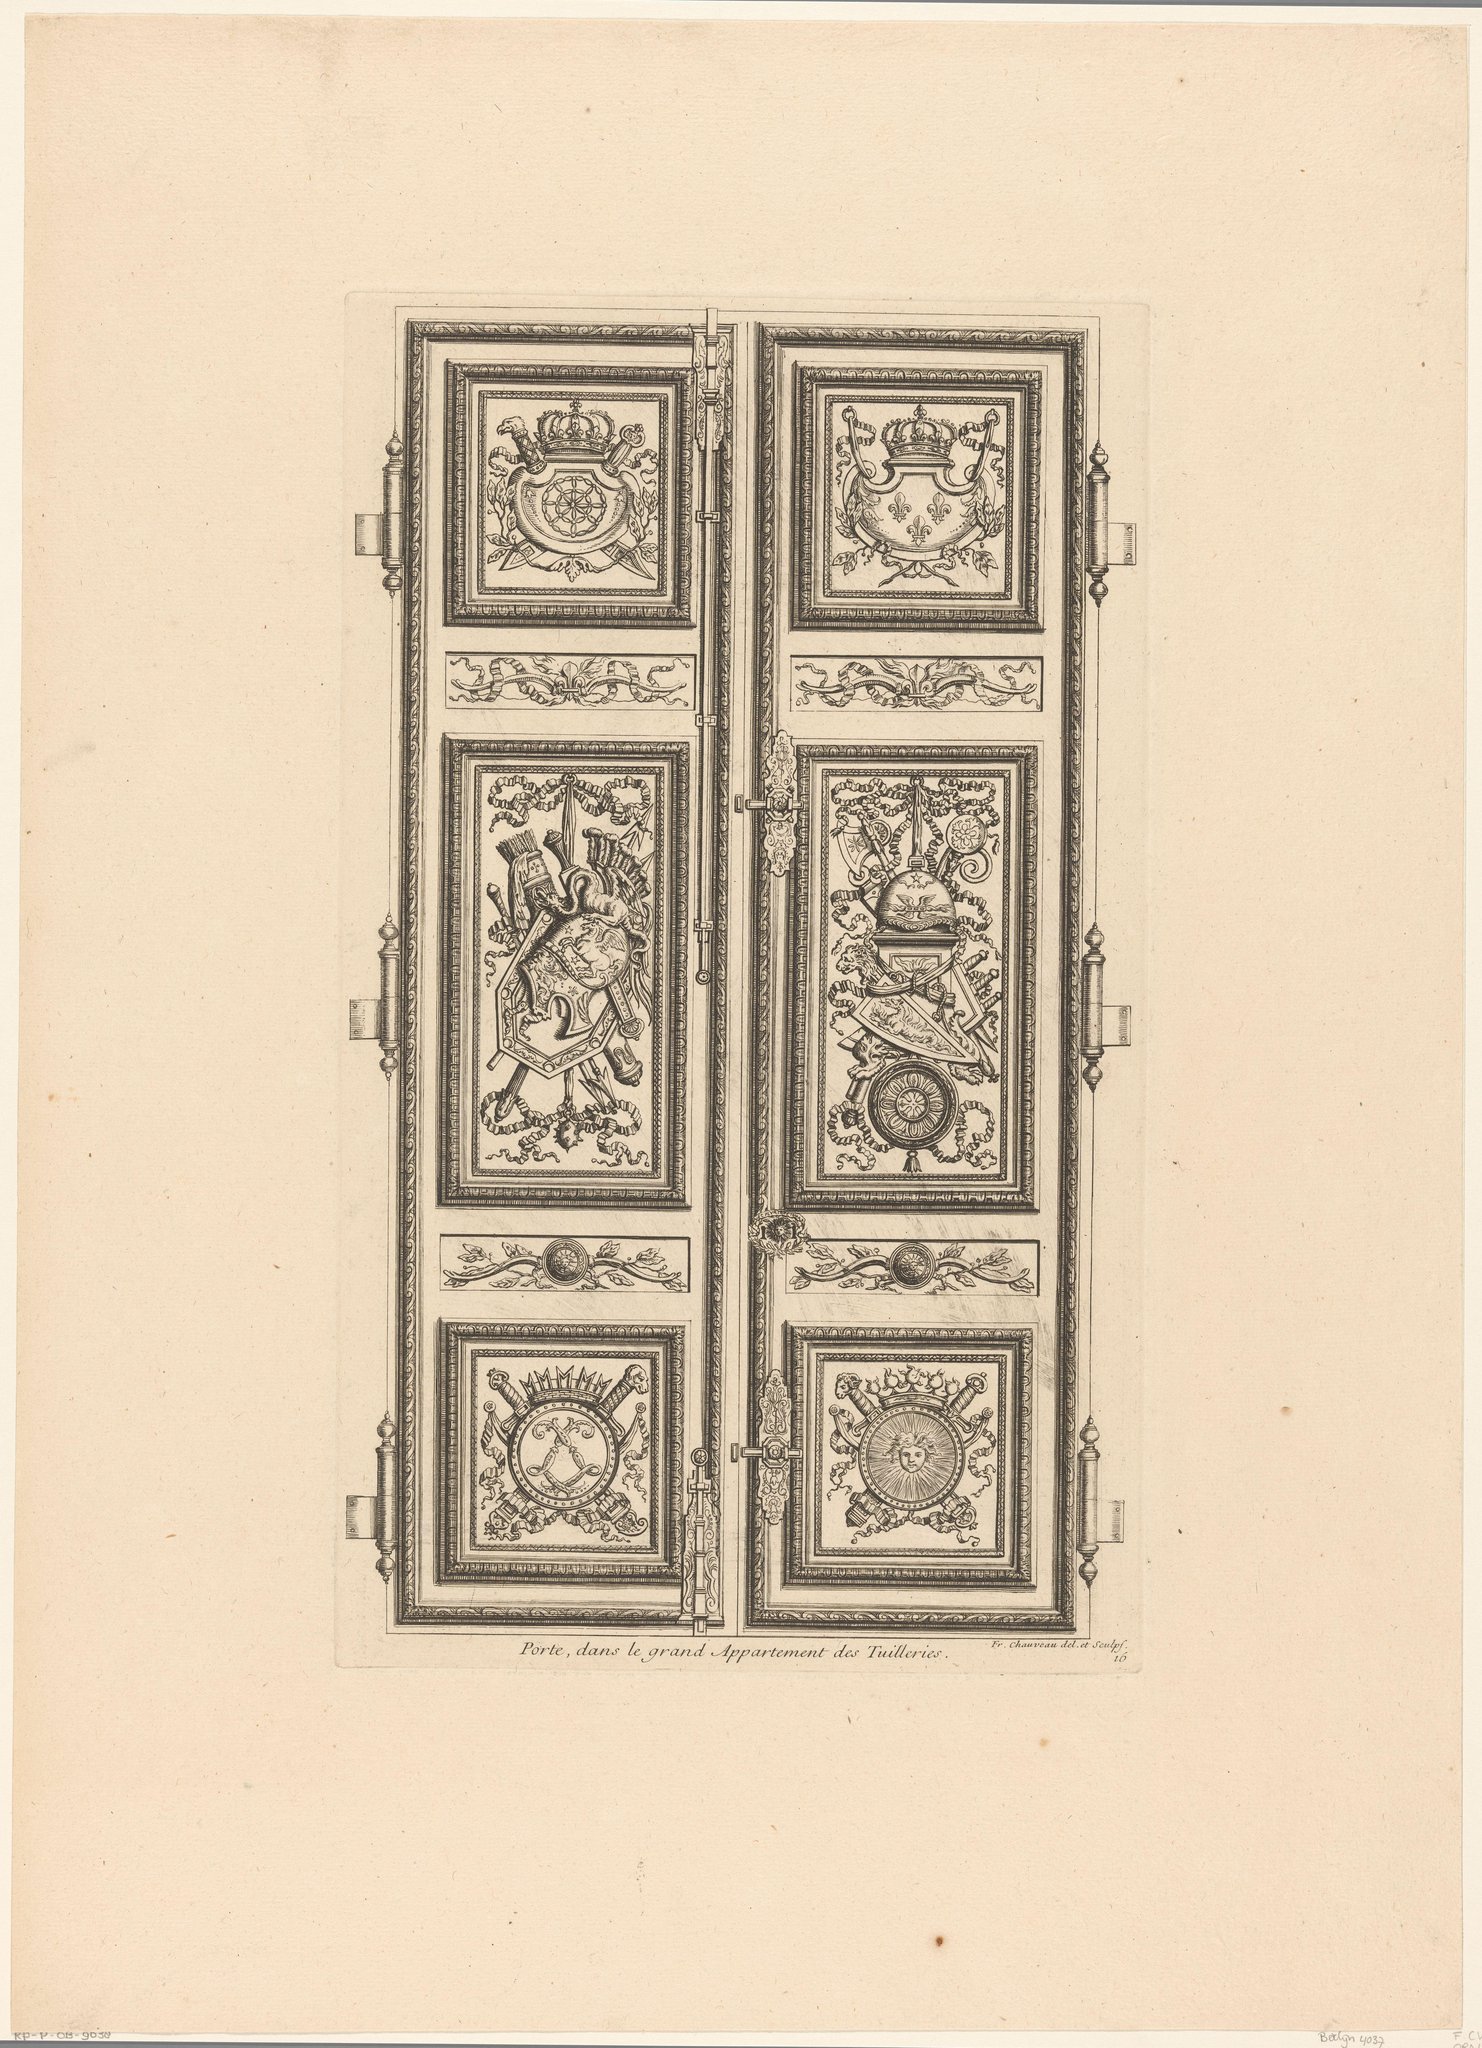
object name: print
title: Ornemens de peintures et de sculpture, qui sont dans la Galerie d'Apollon, au Chasteau du Louvre, et dans le grand Appartement du Roy, au Palais des Tuilleries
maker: françois chauveau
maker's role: draughtsman, painter, print maker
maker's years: 1613-1676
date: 1670-1676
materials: paper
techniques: etching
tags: coat of arms (symbol of sovereignty), trophy, i.e.: decorative arrangement of symbolic or typical objects ~ ornament, door, tuileries palace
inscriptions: collector's mark: Lugt 2228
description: Elf prenten van Jean Bérain le Vieux (RP-P-OB-9624 t/m 9634), dertien prenten van François Chauveau (RP-P-OB-9635 t/m 9647), vier prenten van Lemoine (RP-P-OB-9674 t/m 9677) en een titelprent (in 1710 toegevoegd) vormen tezamen een serie van 29.